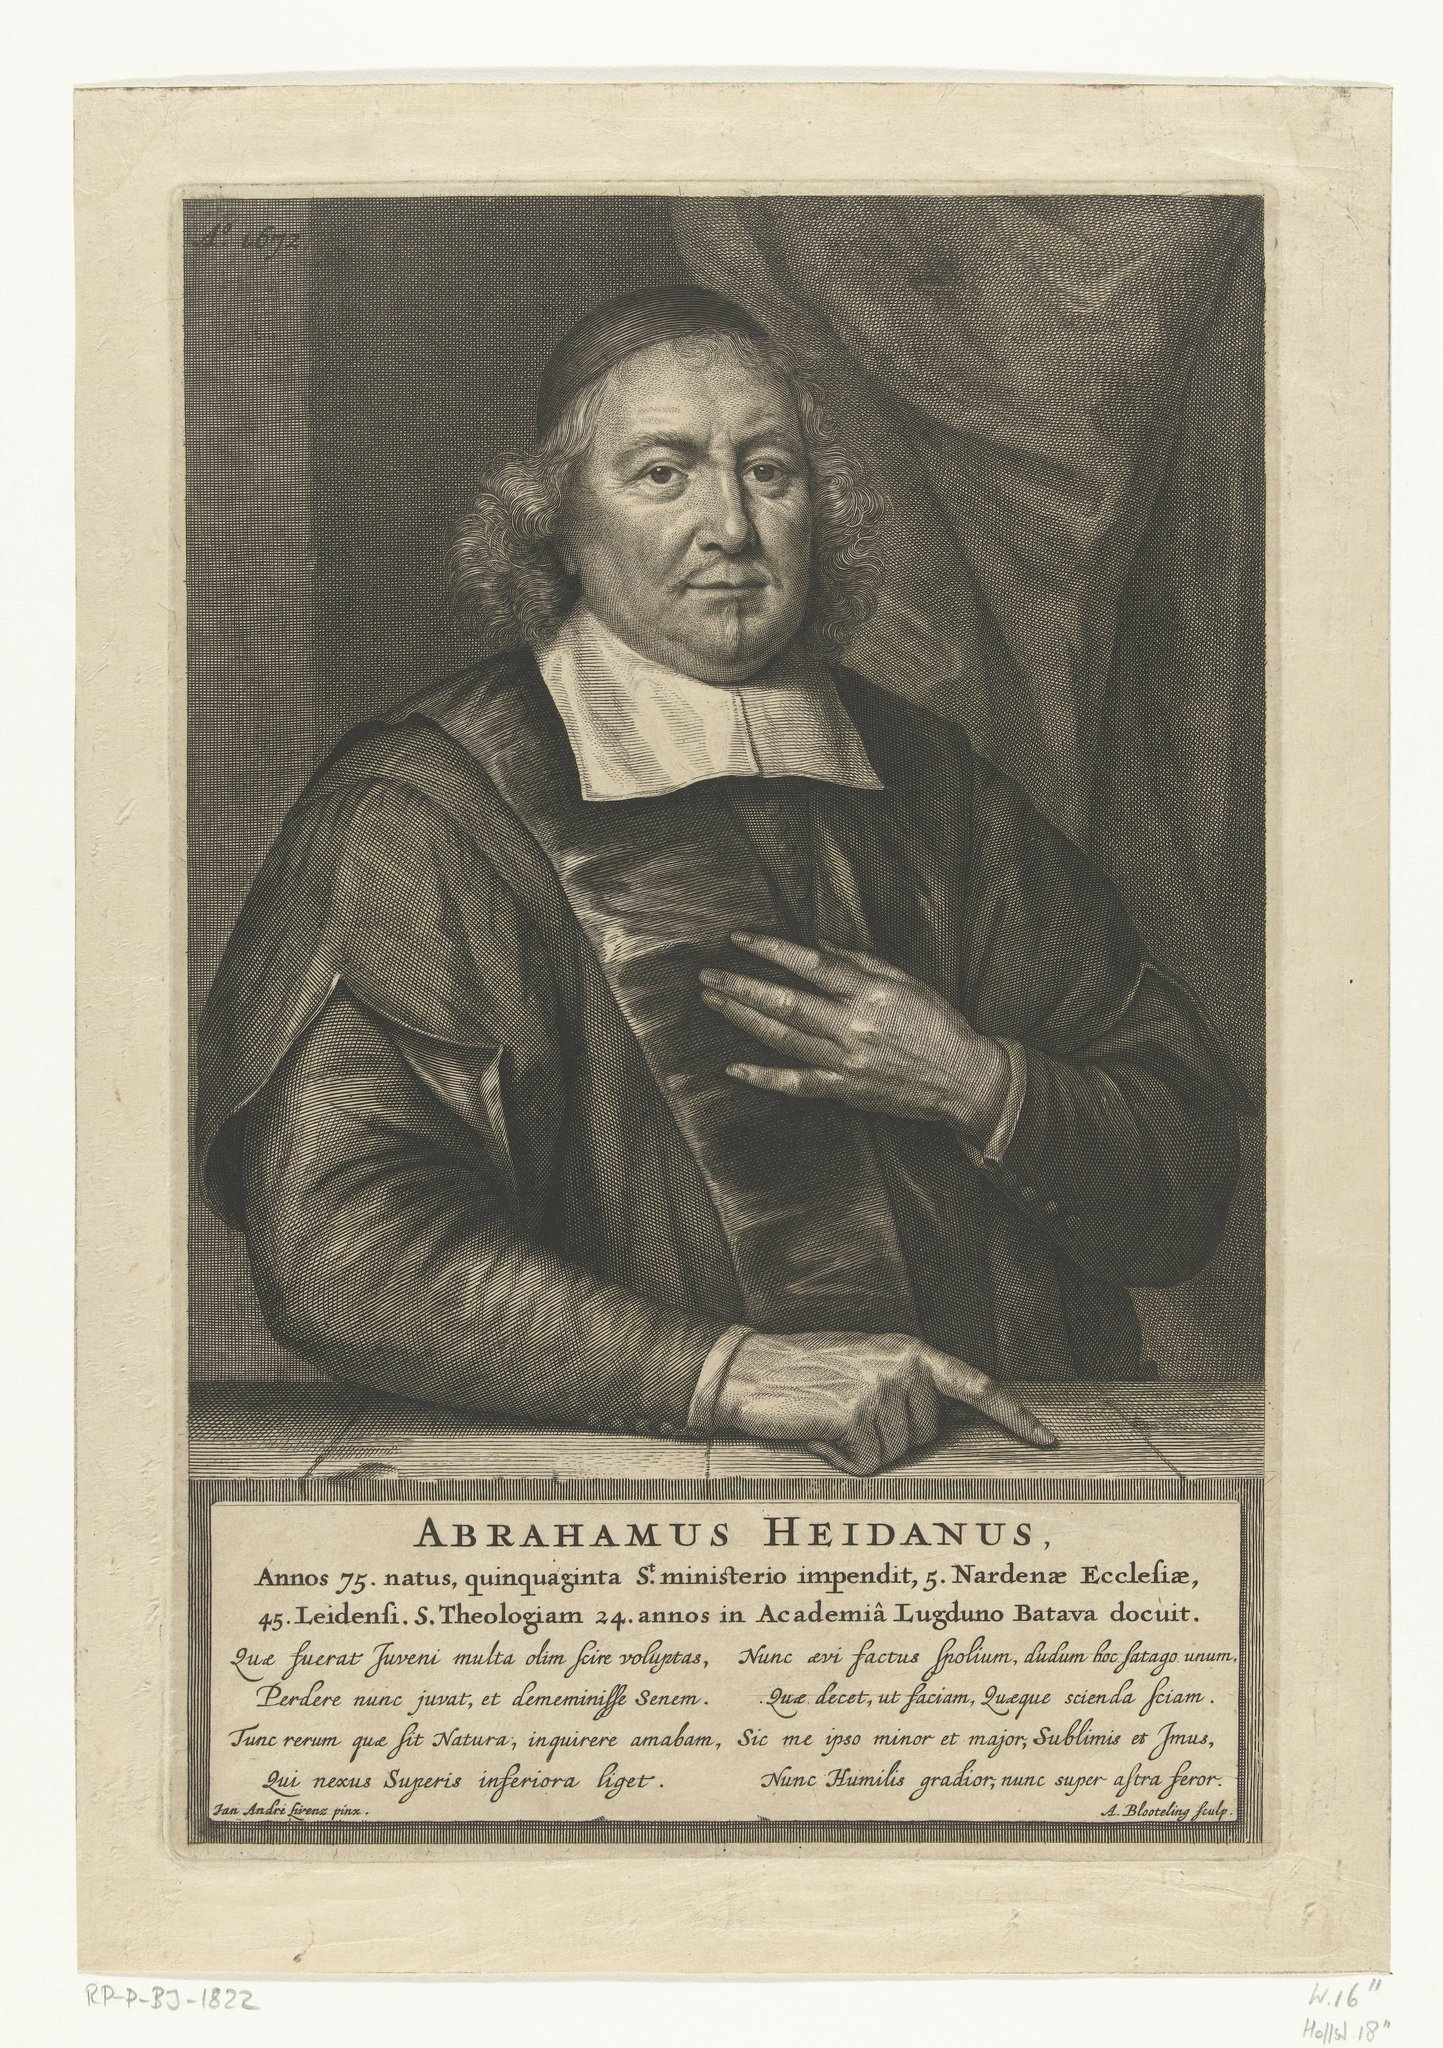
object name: print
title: Portret van Abraham Heidanus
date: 1672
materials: paper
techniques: engraving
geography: amsterdam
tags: functionaries and dignitaries ~ protestant churches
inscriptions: collector's mark: Lugt 2228, collector's mark: Lugt 240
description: Borstbeeld van de predikant en hoogleraar aan de Leidse Universiteit Abraham Heidanus. Onder het portret zijn naam en een opsomming van de gemeentes waar hij werkzaam was, en een vers in het Latijn.